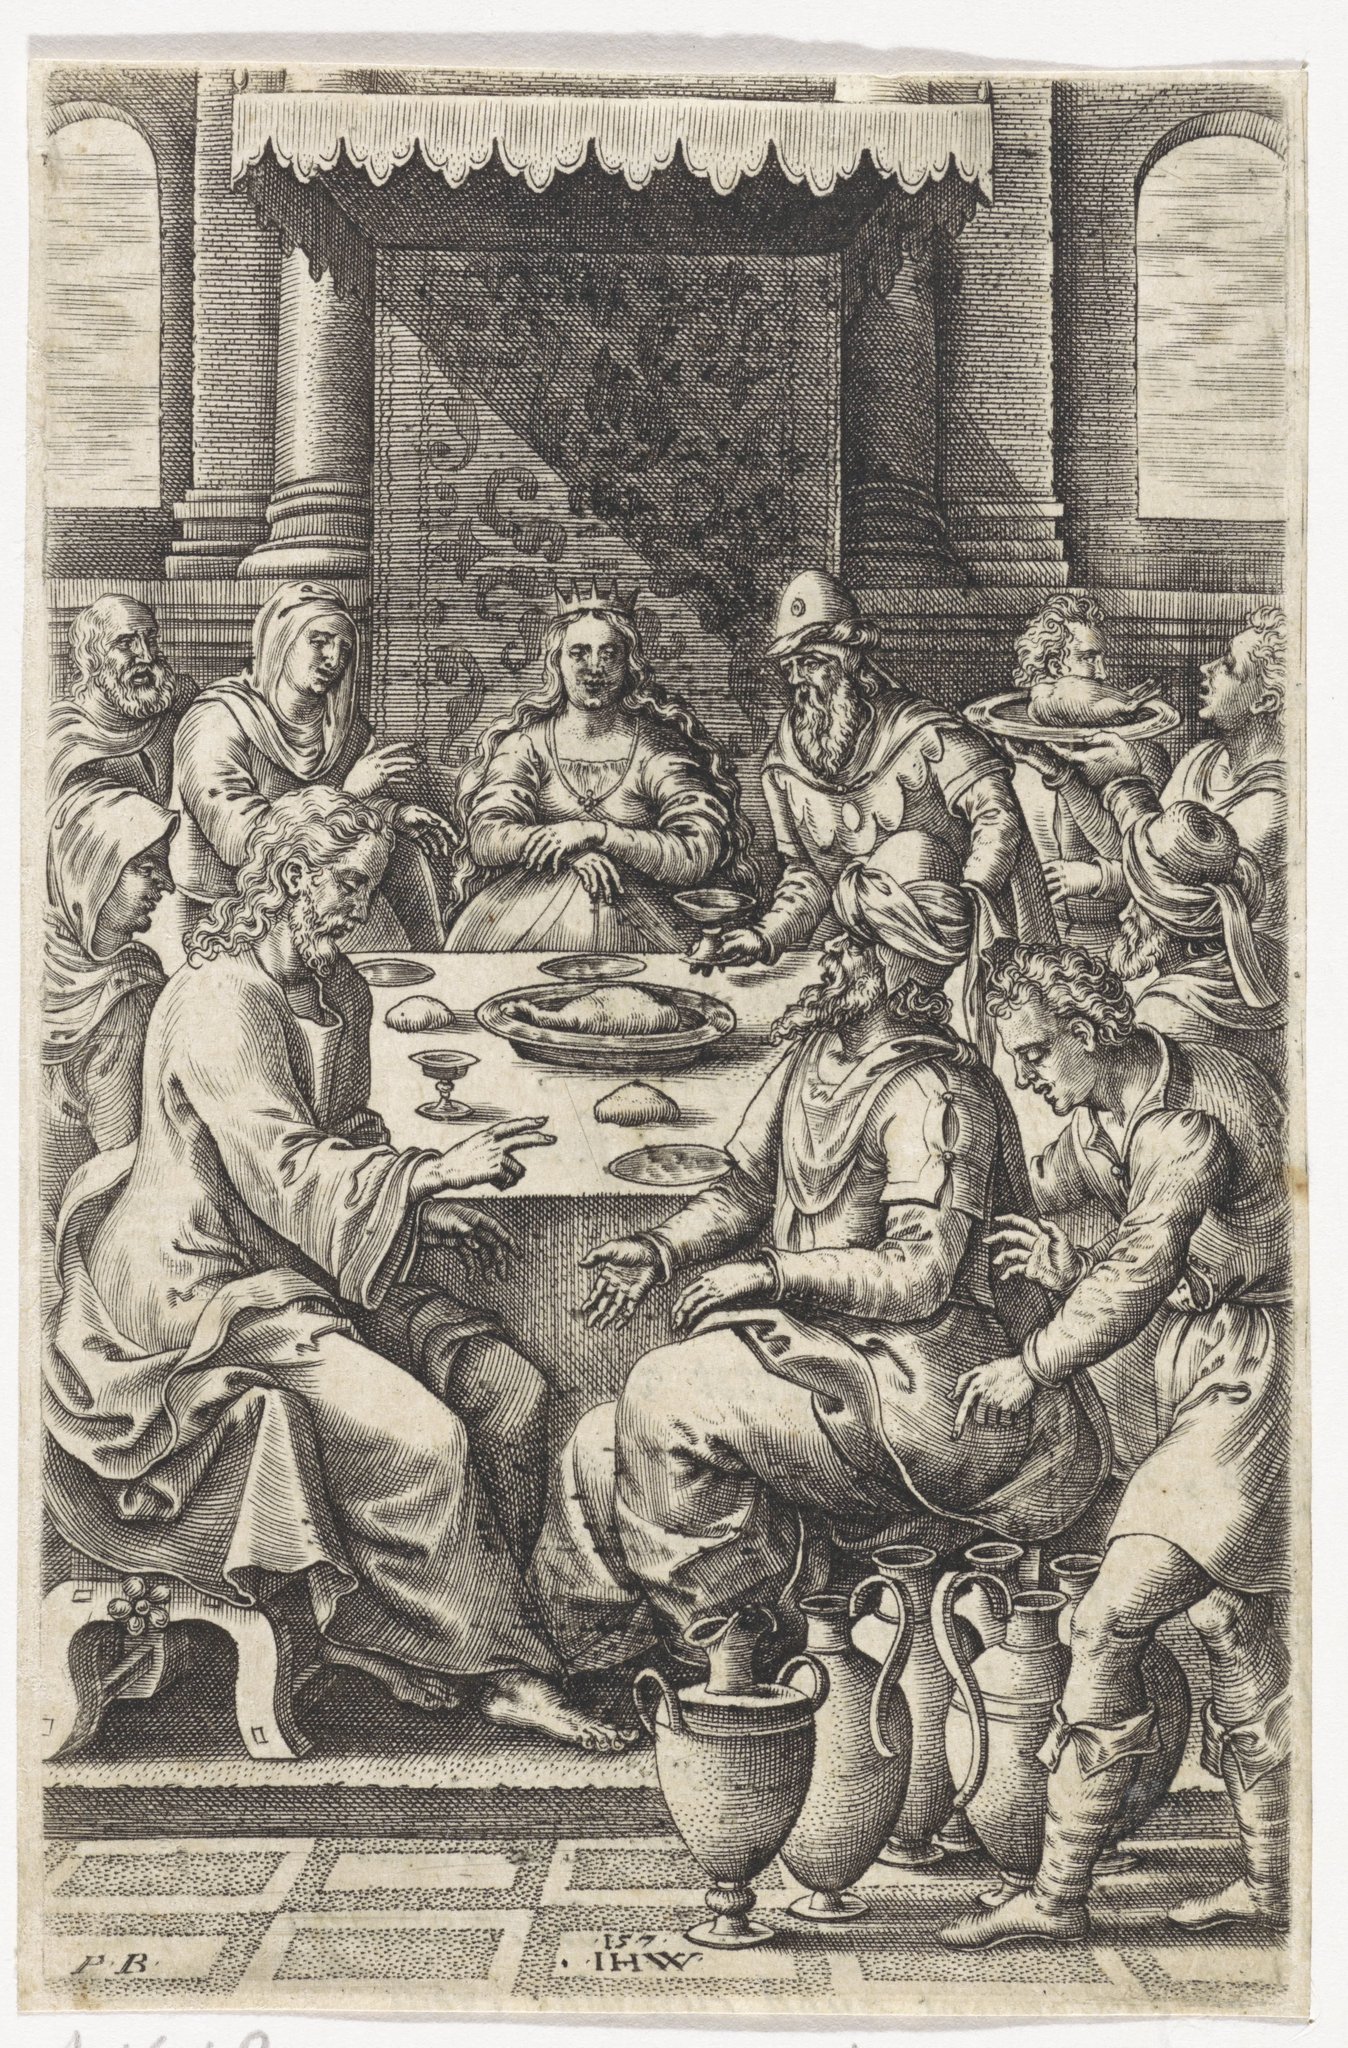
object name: print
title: Bruiloft te Kana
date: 1571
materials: paper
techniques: engraving, letterpress printing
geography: antwerp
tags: christ orders (six) jars to be filled with water ~ marriage-feast at cana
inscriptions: number: ‘46’, collector's mark: Lugt 2228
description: Het bruidspaar en de gasten zitten rond een tafel. Christus zegent de wijnvaten waarp het water in de vaten in wijn veranderd.